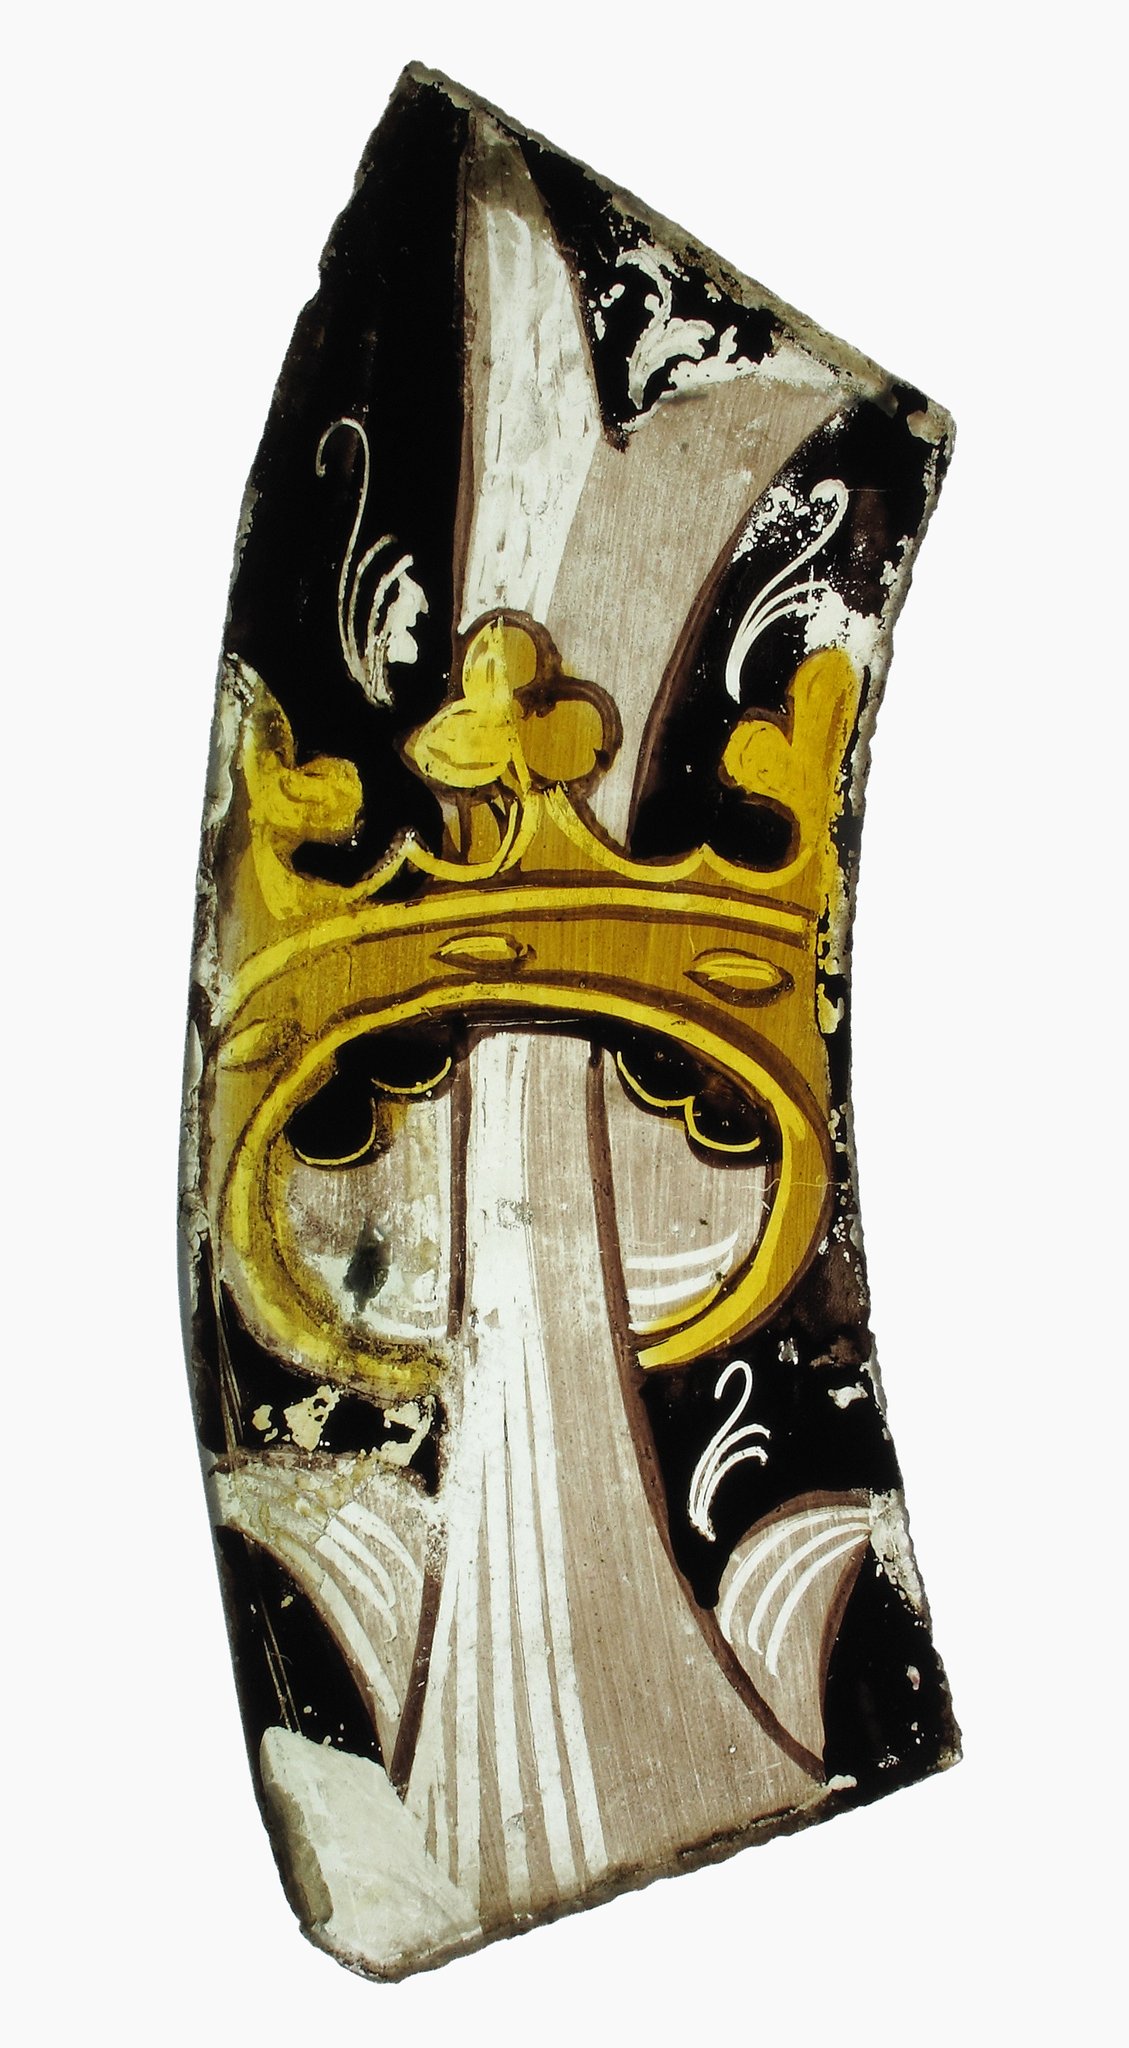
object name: fragment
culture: british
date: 1401-1500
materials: glass, metal, paint